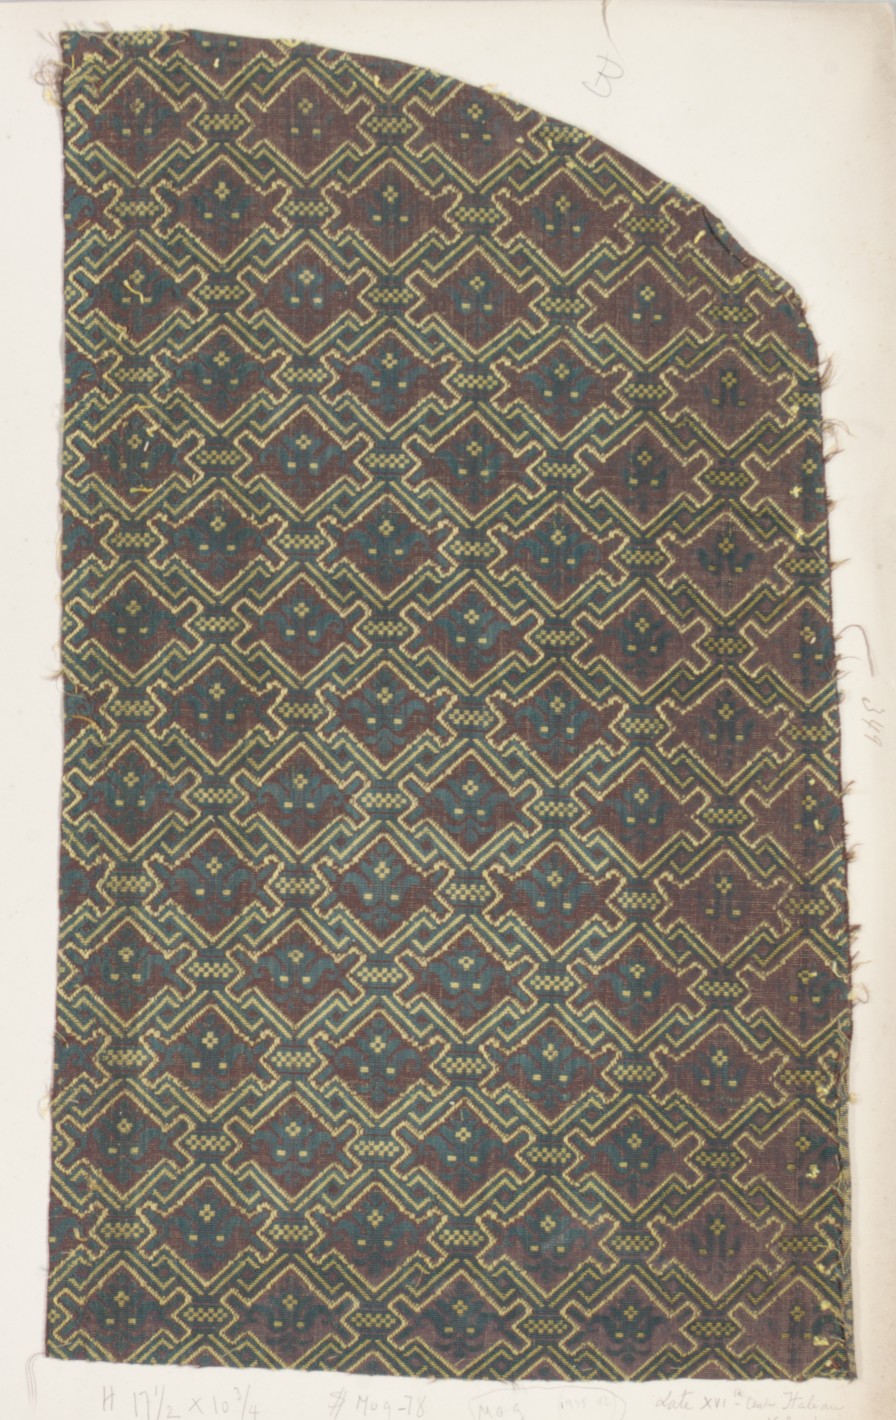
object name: fragment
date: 1567-1600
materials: silk